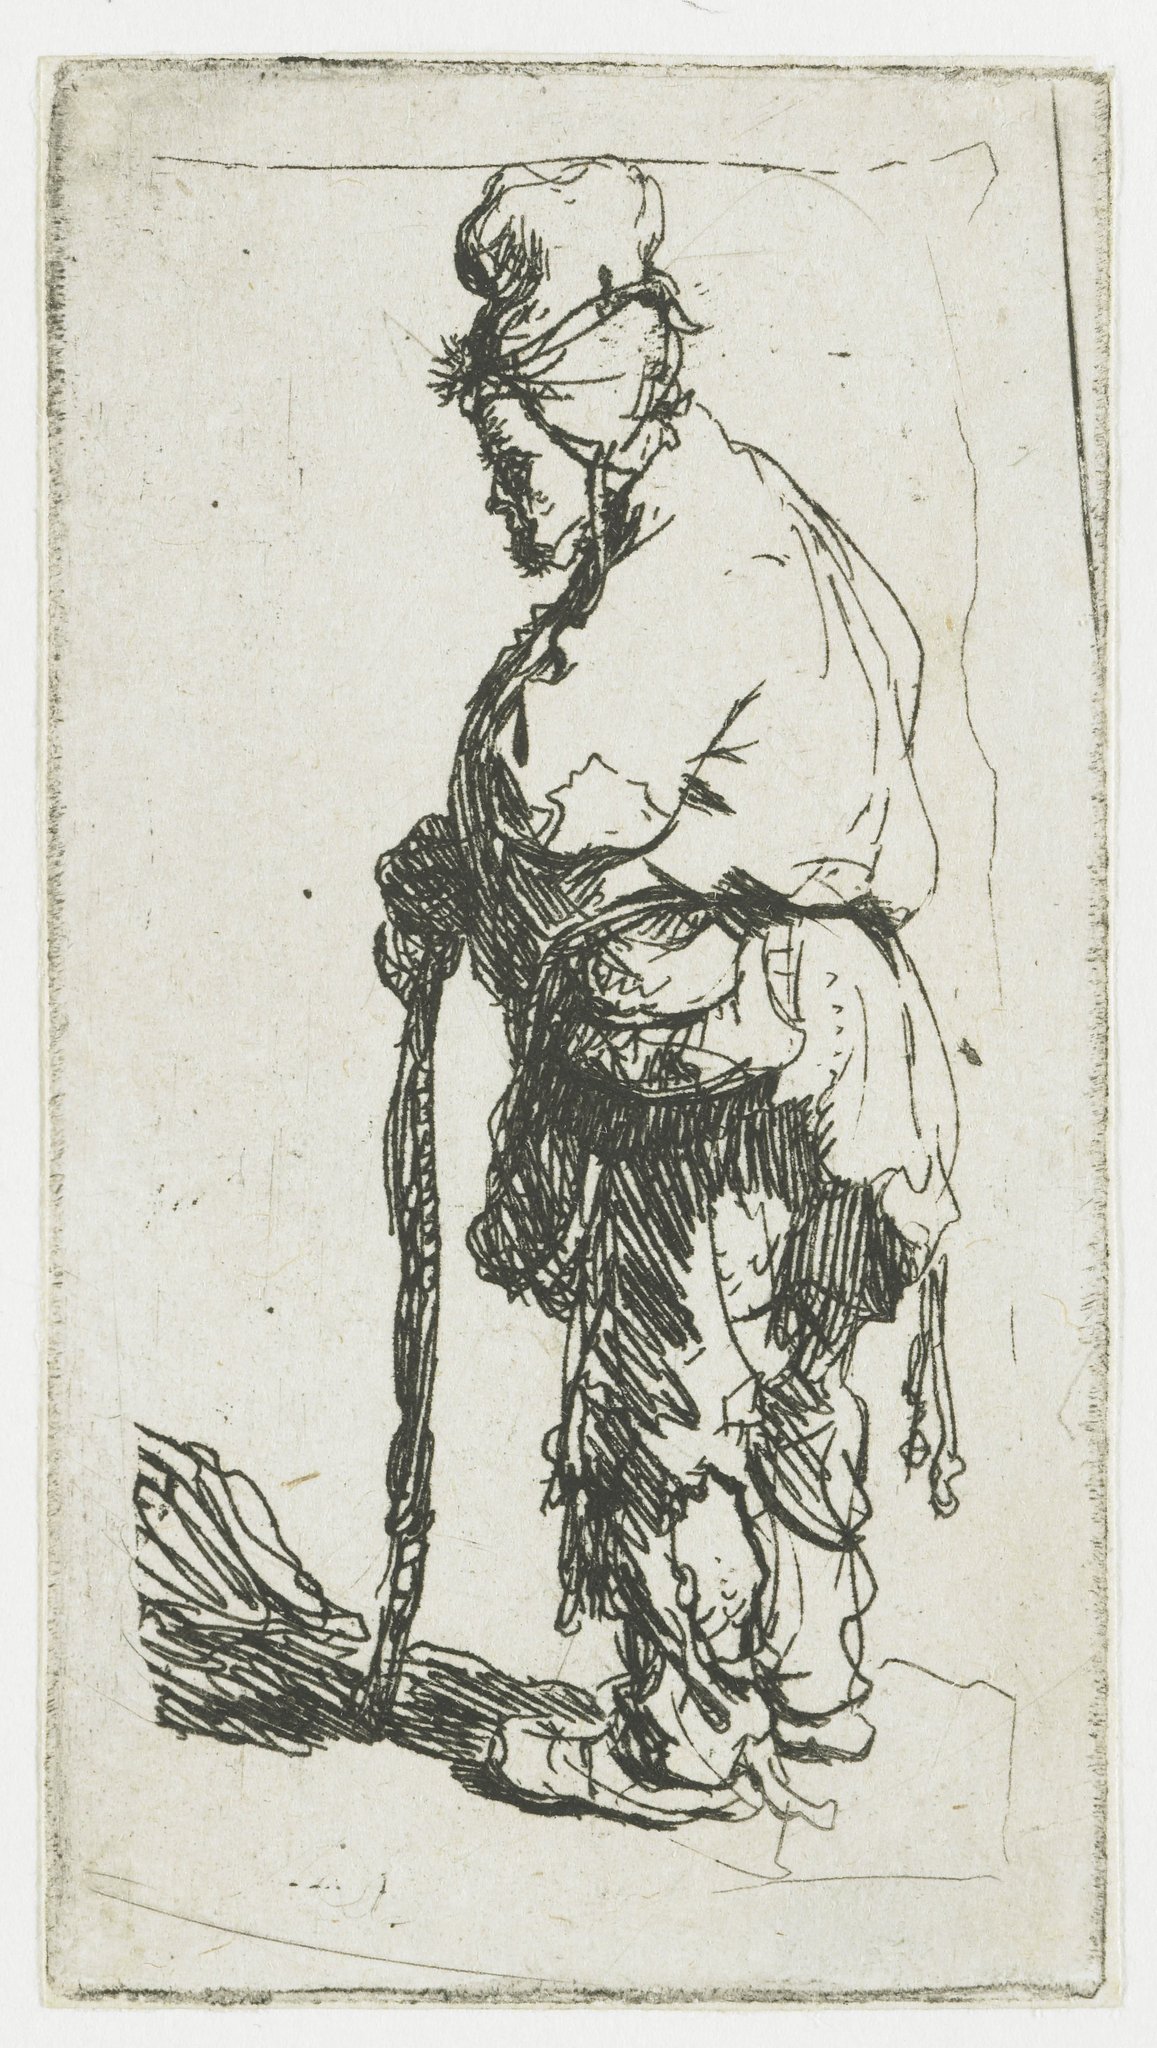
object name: print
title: Beggar leaning on a stick, facing left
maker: rembrandt van rijn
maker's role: draughtsman, painter, print maker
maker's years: 1606-1669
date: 1630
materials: paper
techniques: etching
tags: beggar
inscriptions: collector's mark: Lugt 240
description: Rembrandt etched the largest of these three beggars in exactly the same style as the figures in the adjacent drawings. He indicated all of the shadows with vertical parallel lines. This hatching adds verve to the depiction, but is also somewhat coarse. In the two other etchings, he achieved a more refined result using the same style in a much smaller format.